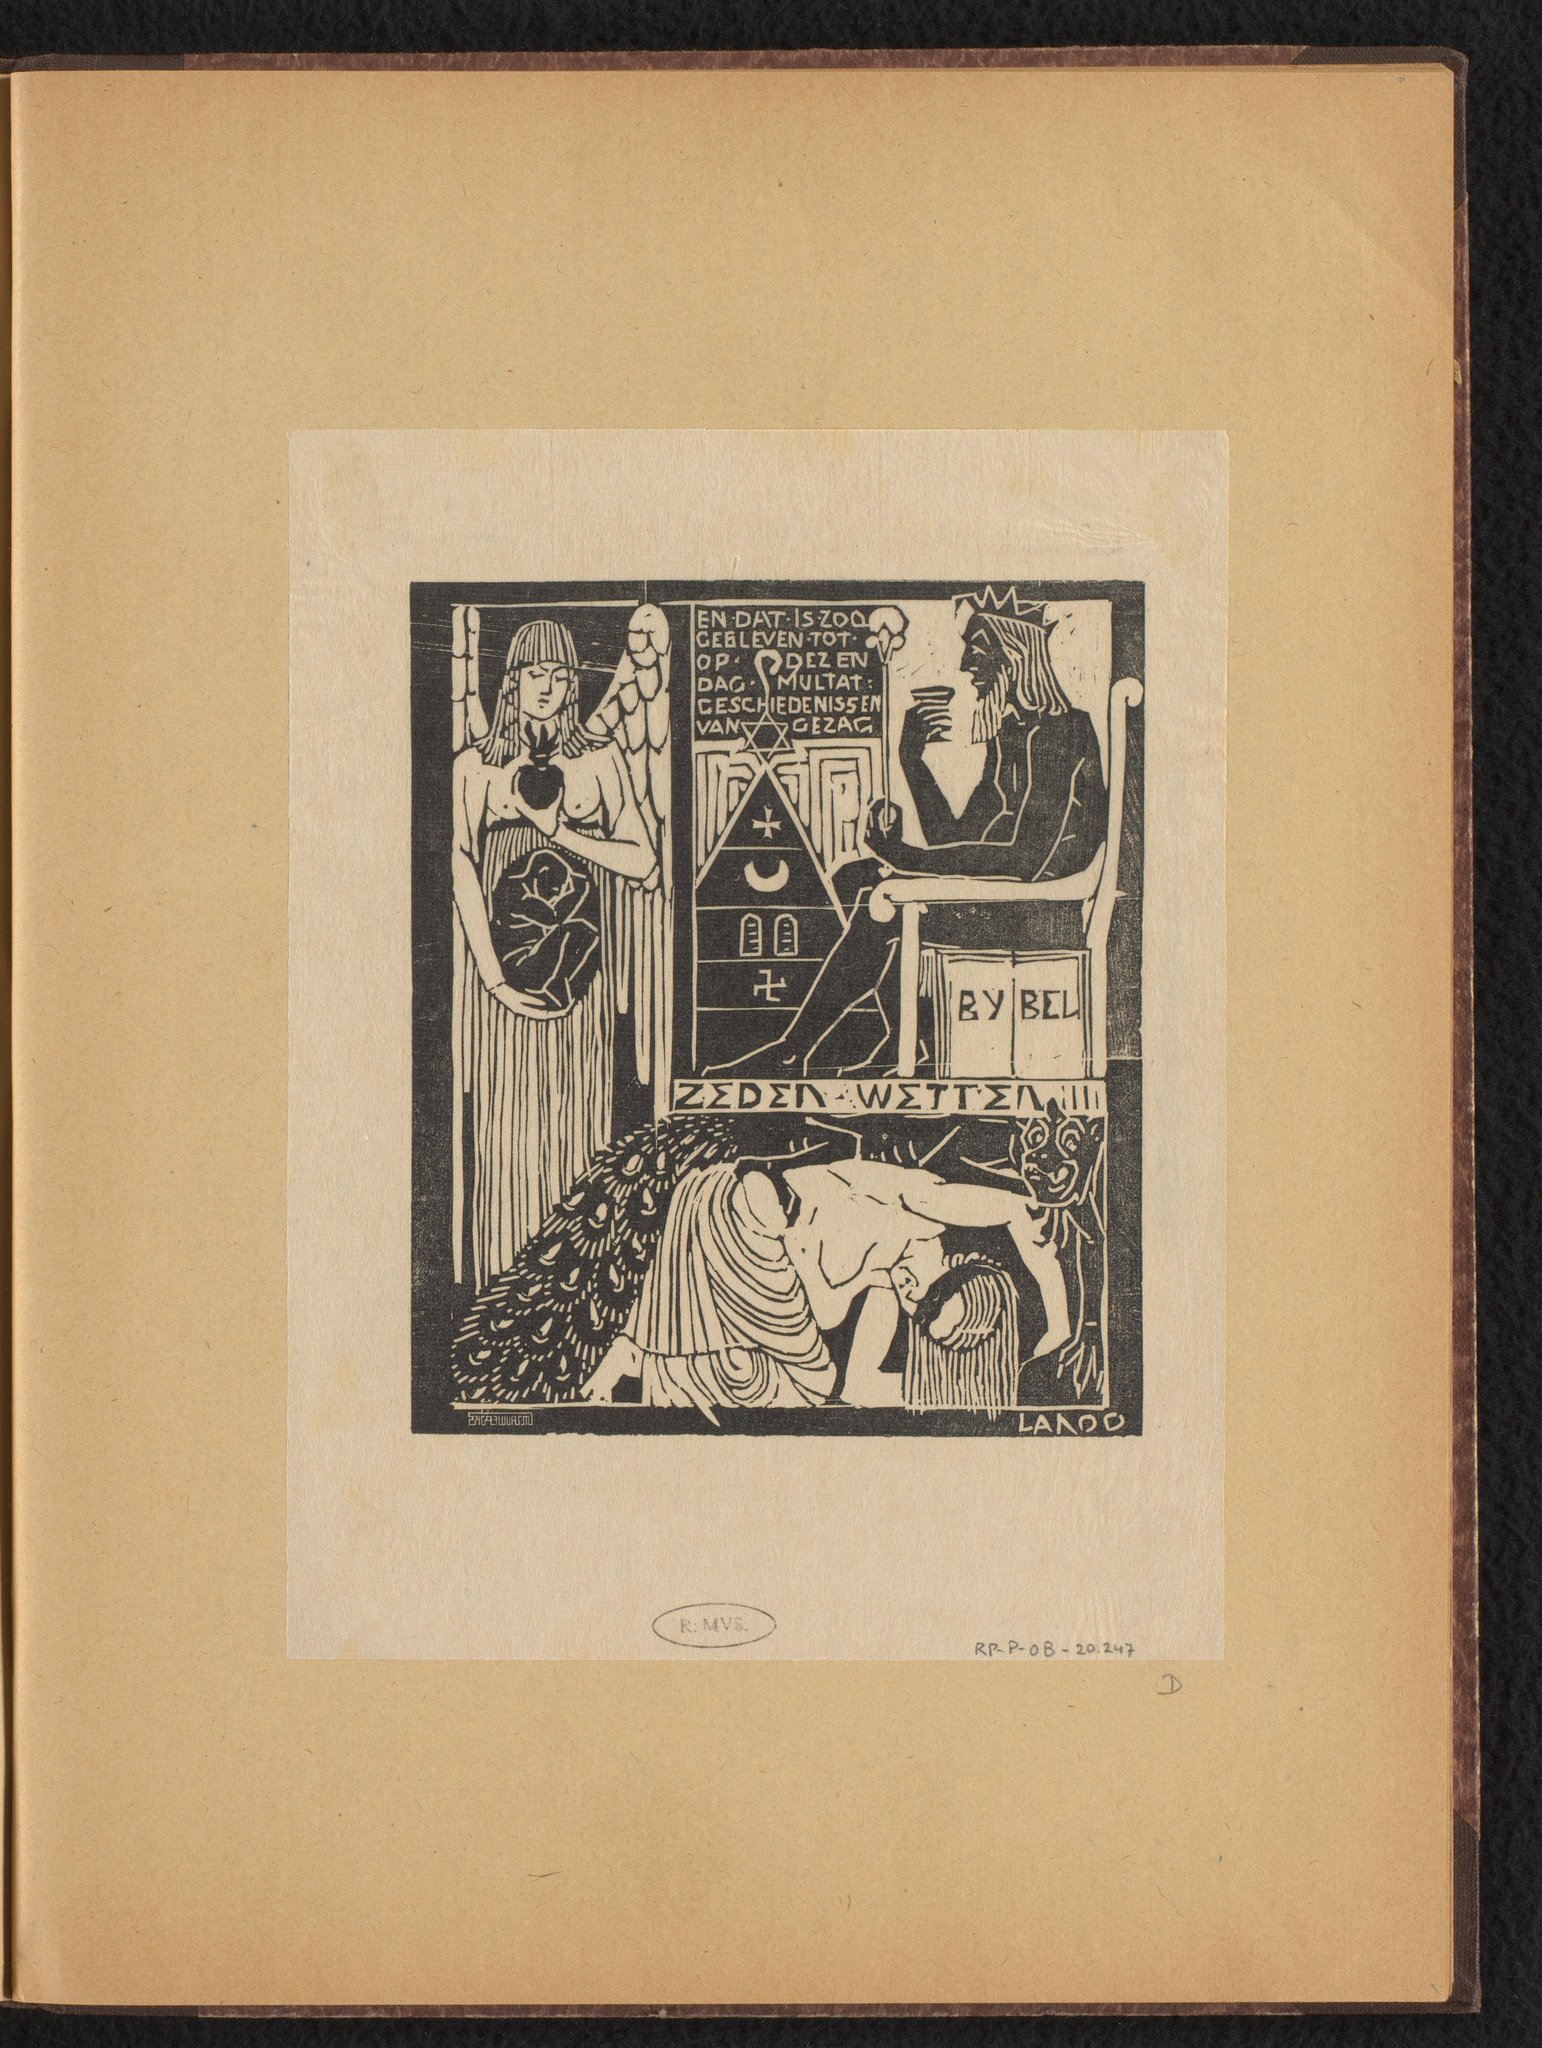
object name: illustration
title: Geblinddoekte vrouw en monster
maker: mathieu lauweriks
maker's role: designer, draughtsman, print maker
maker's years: 1864-1932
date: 1894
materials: paper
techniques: woodcut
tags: uterus with foetus - aa - female human figure, monsters ~ animals in general (of undetermined kind), the sacred heart, blindfold - aa - female human figure, the bible as a book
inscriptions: collector's mark: Lugt 2228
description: Een geblinddoekte vrouw zit op haar knieën met op haar rug een monster met een pauwenstaart. Boven haar de tekst 'zeden - wetten' en een bijbel. Daarboven zit een man met een kroon en een scepter op een stoel. Links staat een gevleugelde vrouw met in haar hand een heilig hart en in haar buik een figuur in foetushouding. Deze prent maakt deel uit van een album.